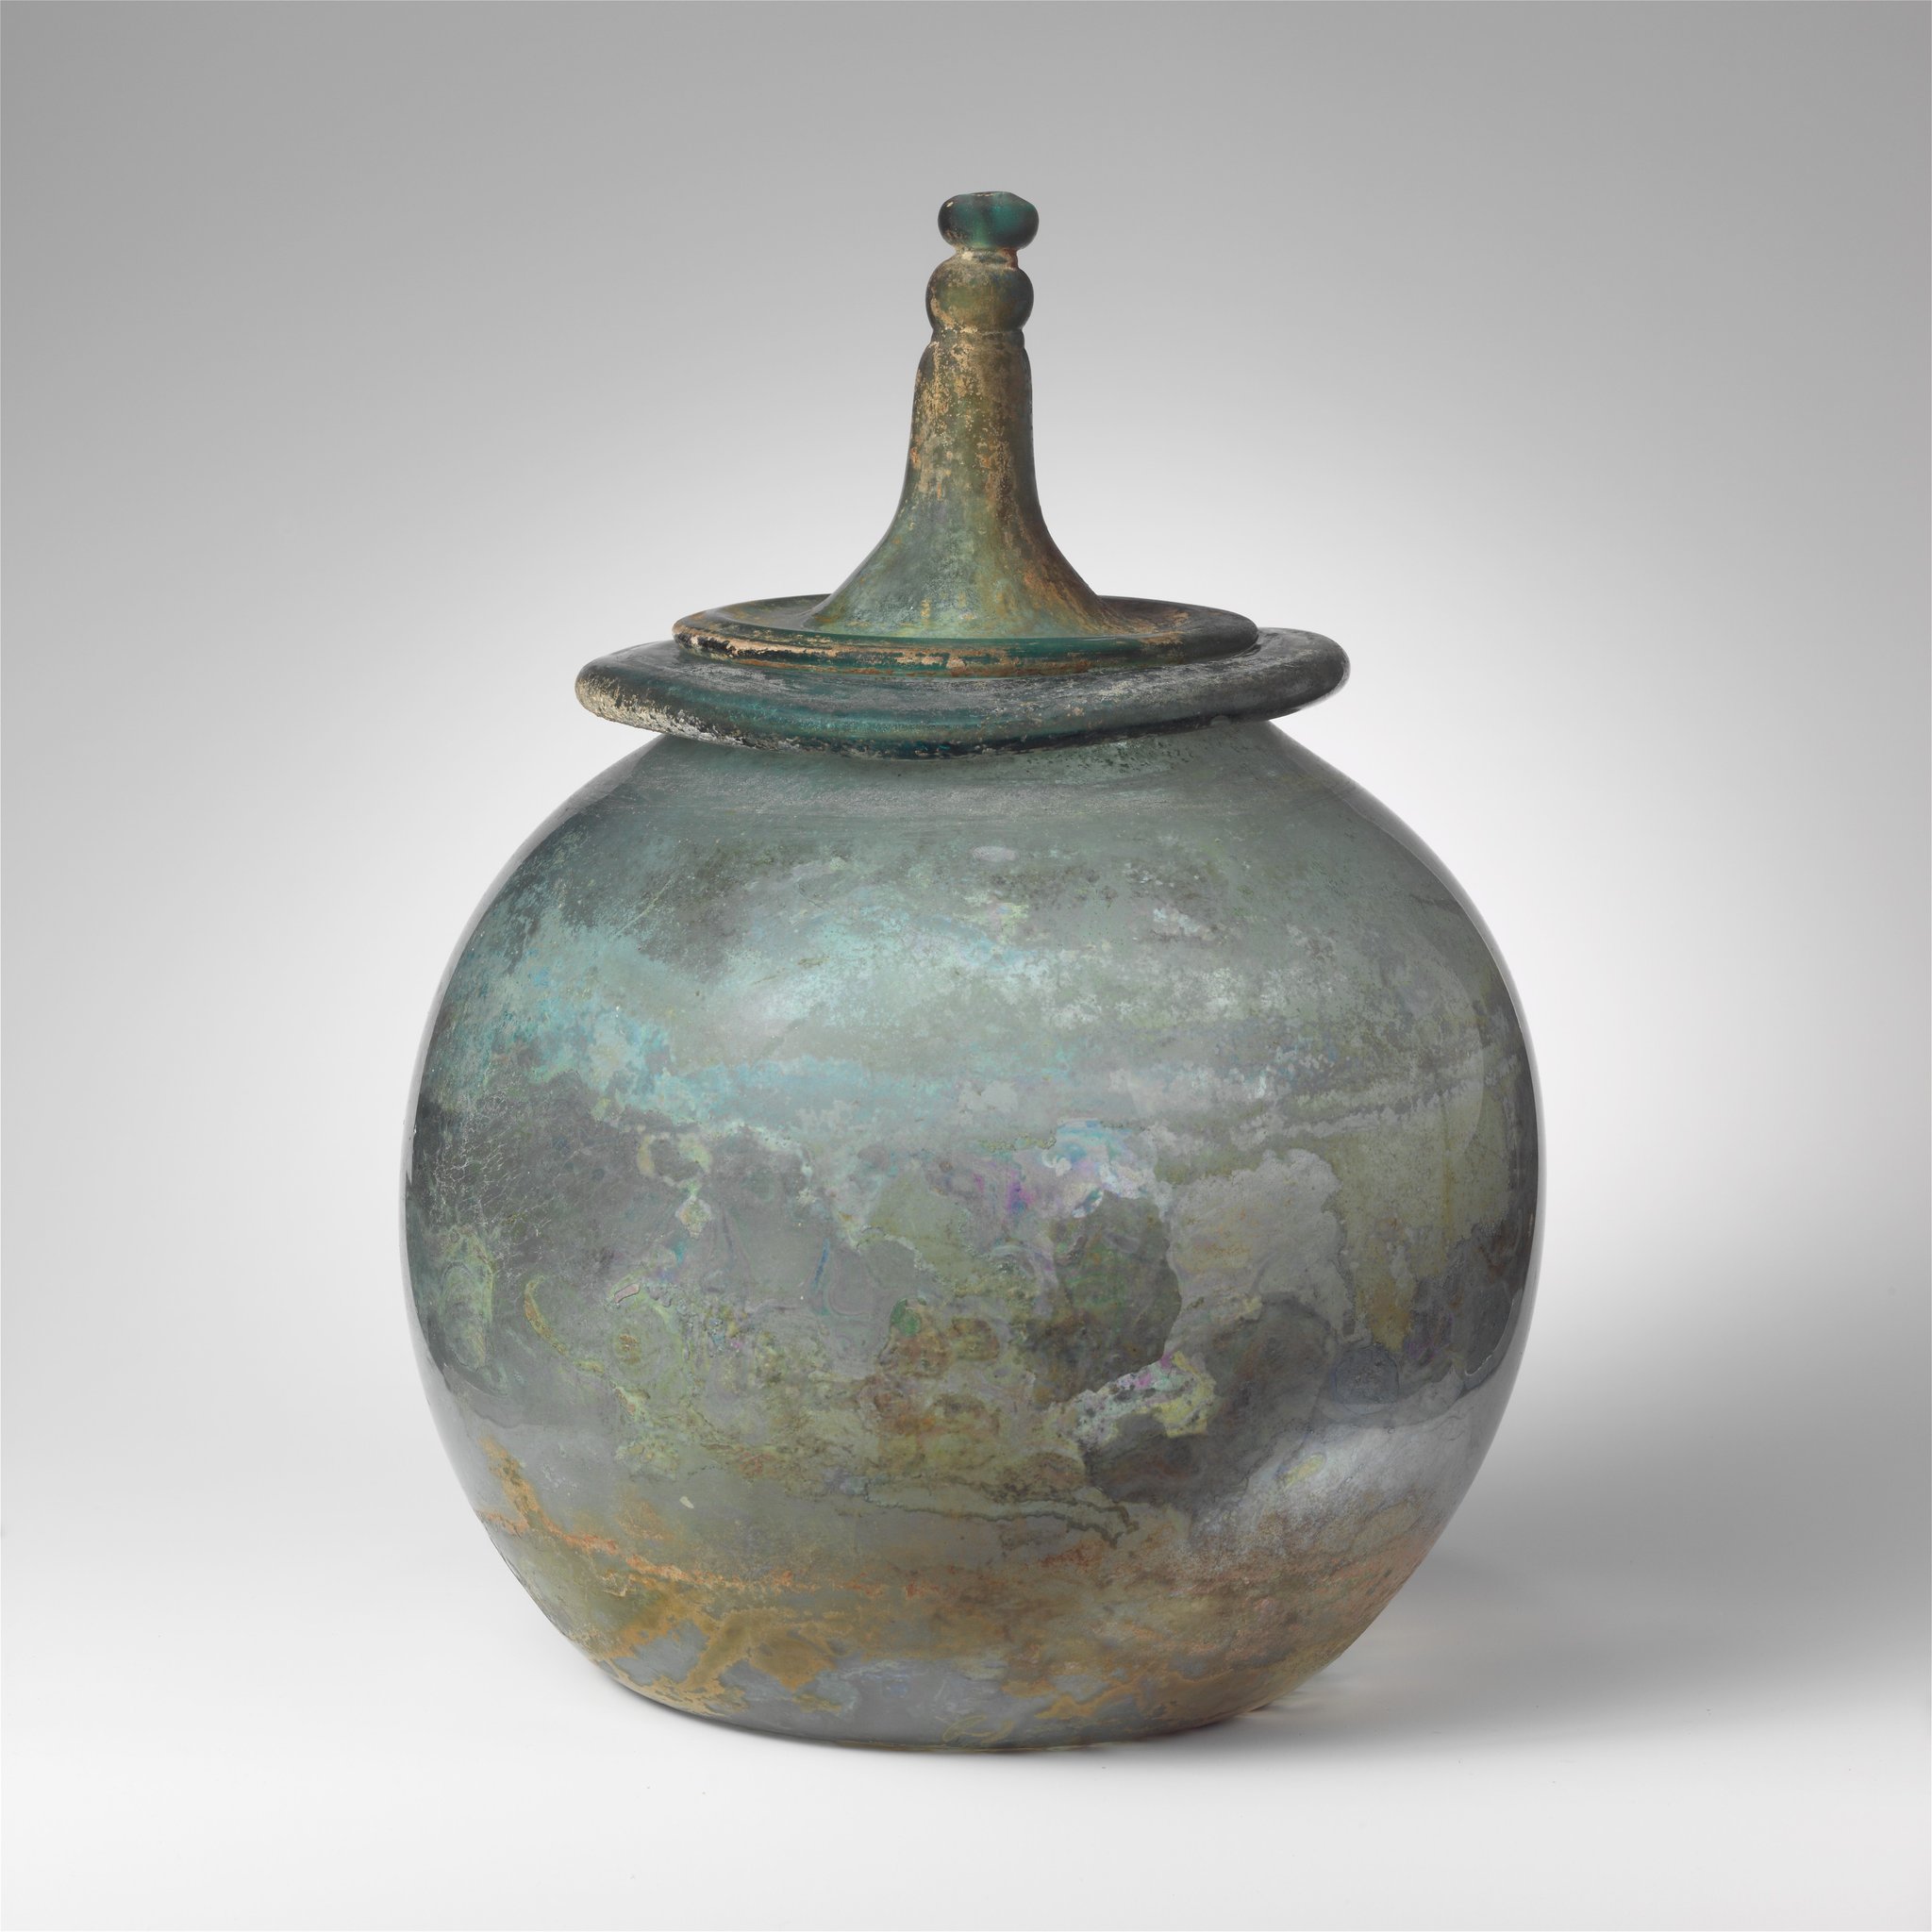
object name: urn with lid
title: Glass cinerary urn with lid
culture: roman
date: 1-133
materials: glass